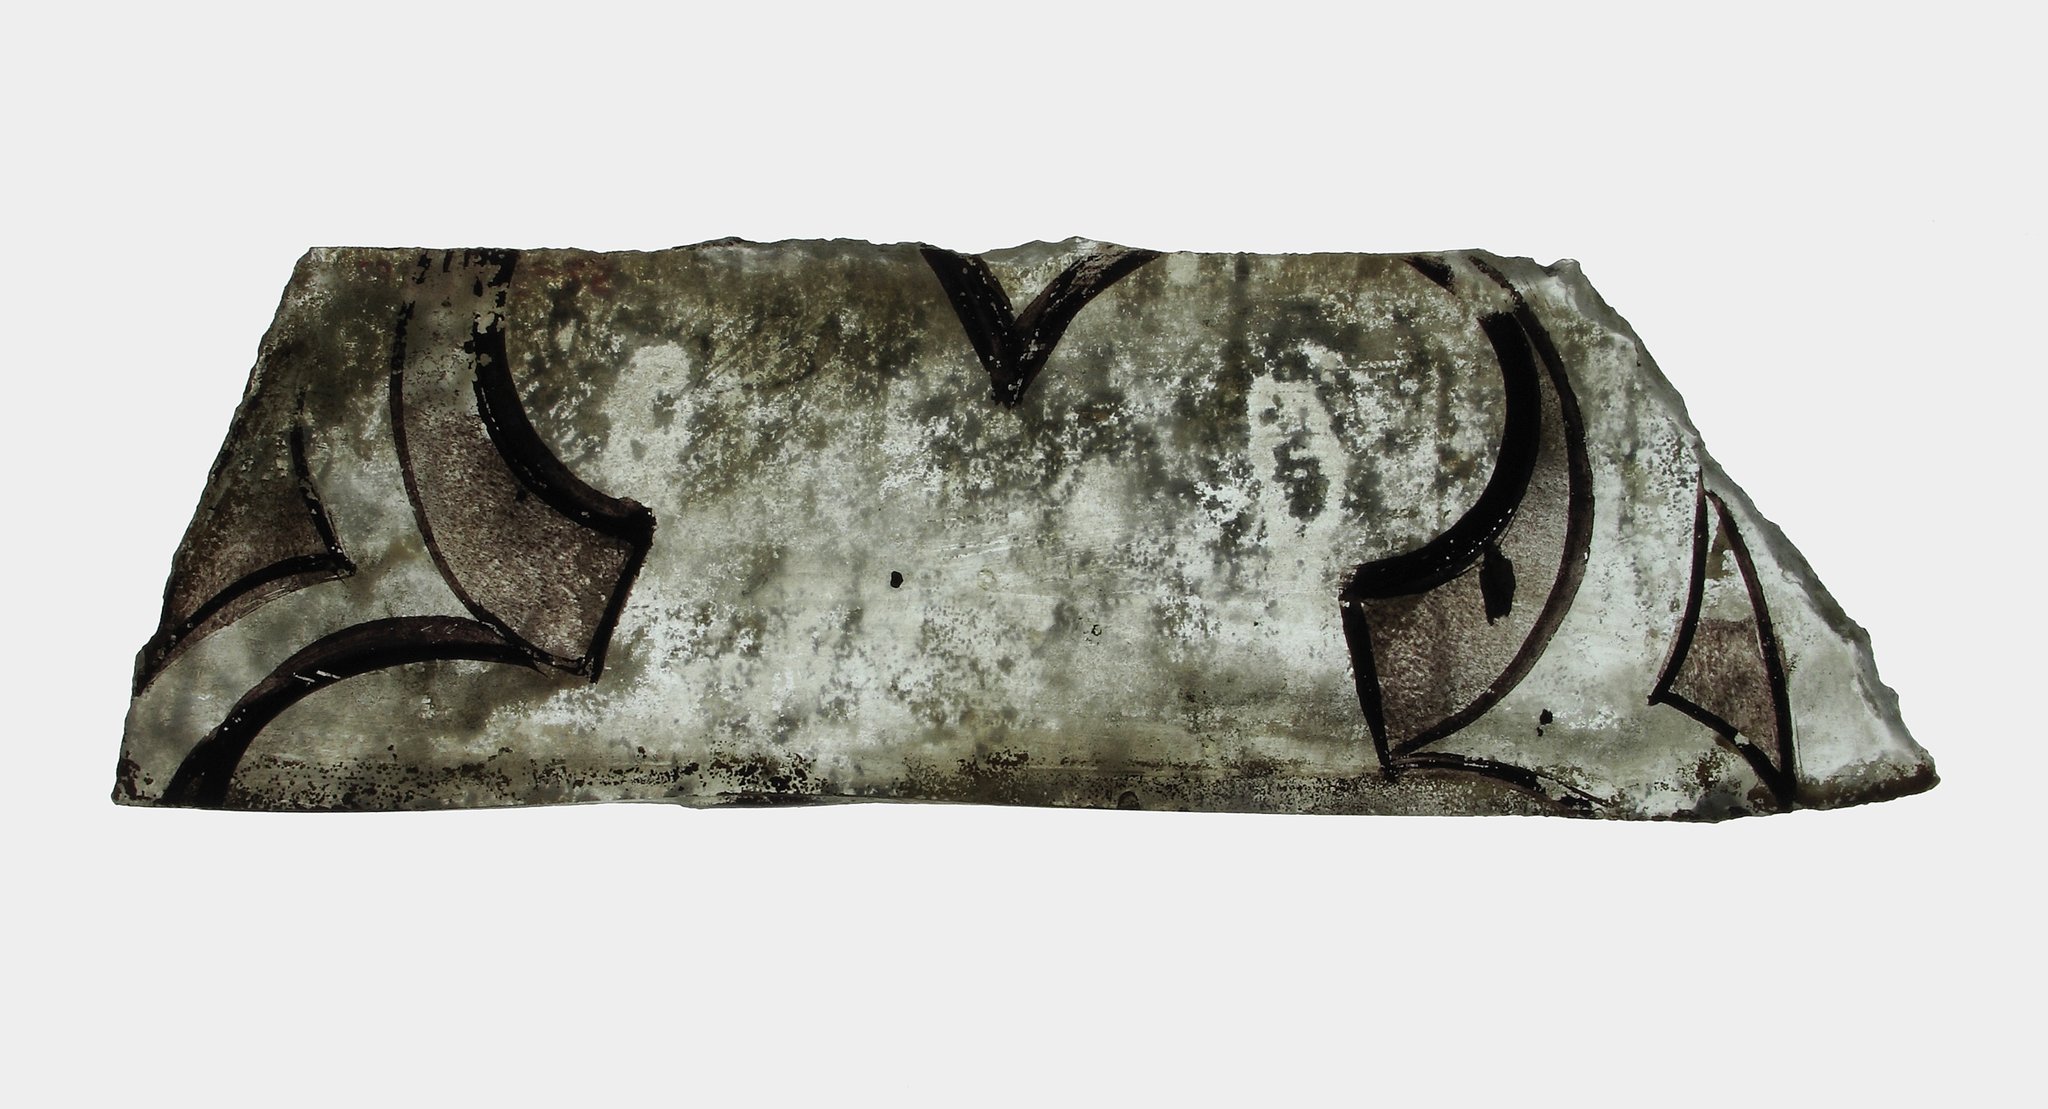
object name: fragment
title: Glass Fragment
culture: french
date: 1401-1500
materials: glass